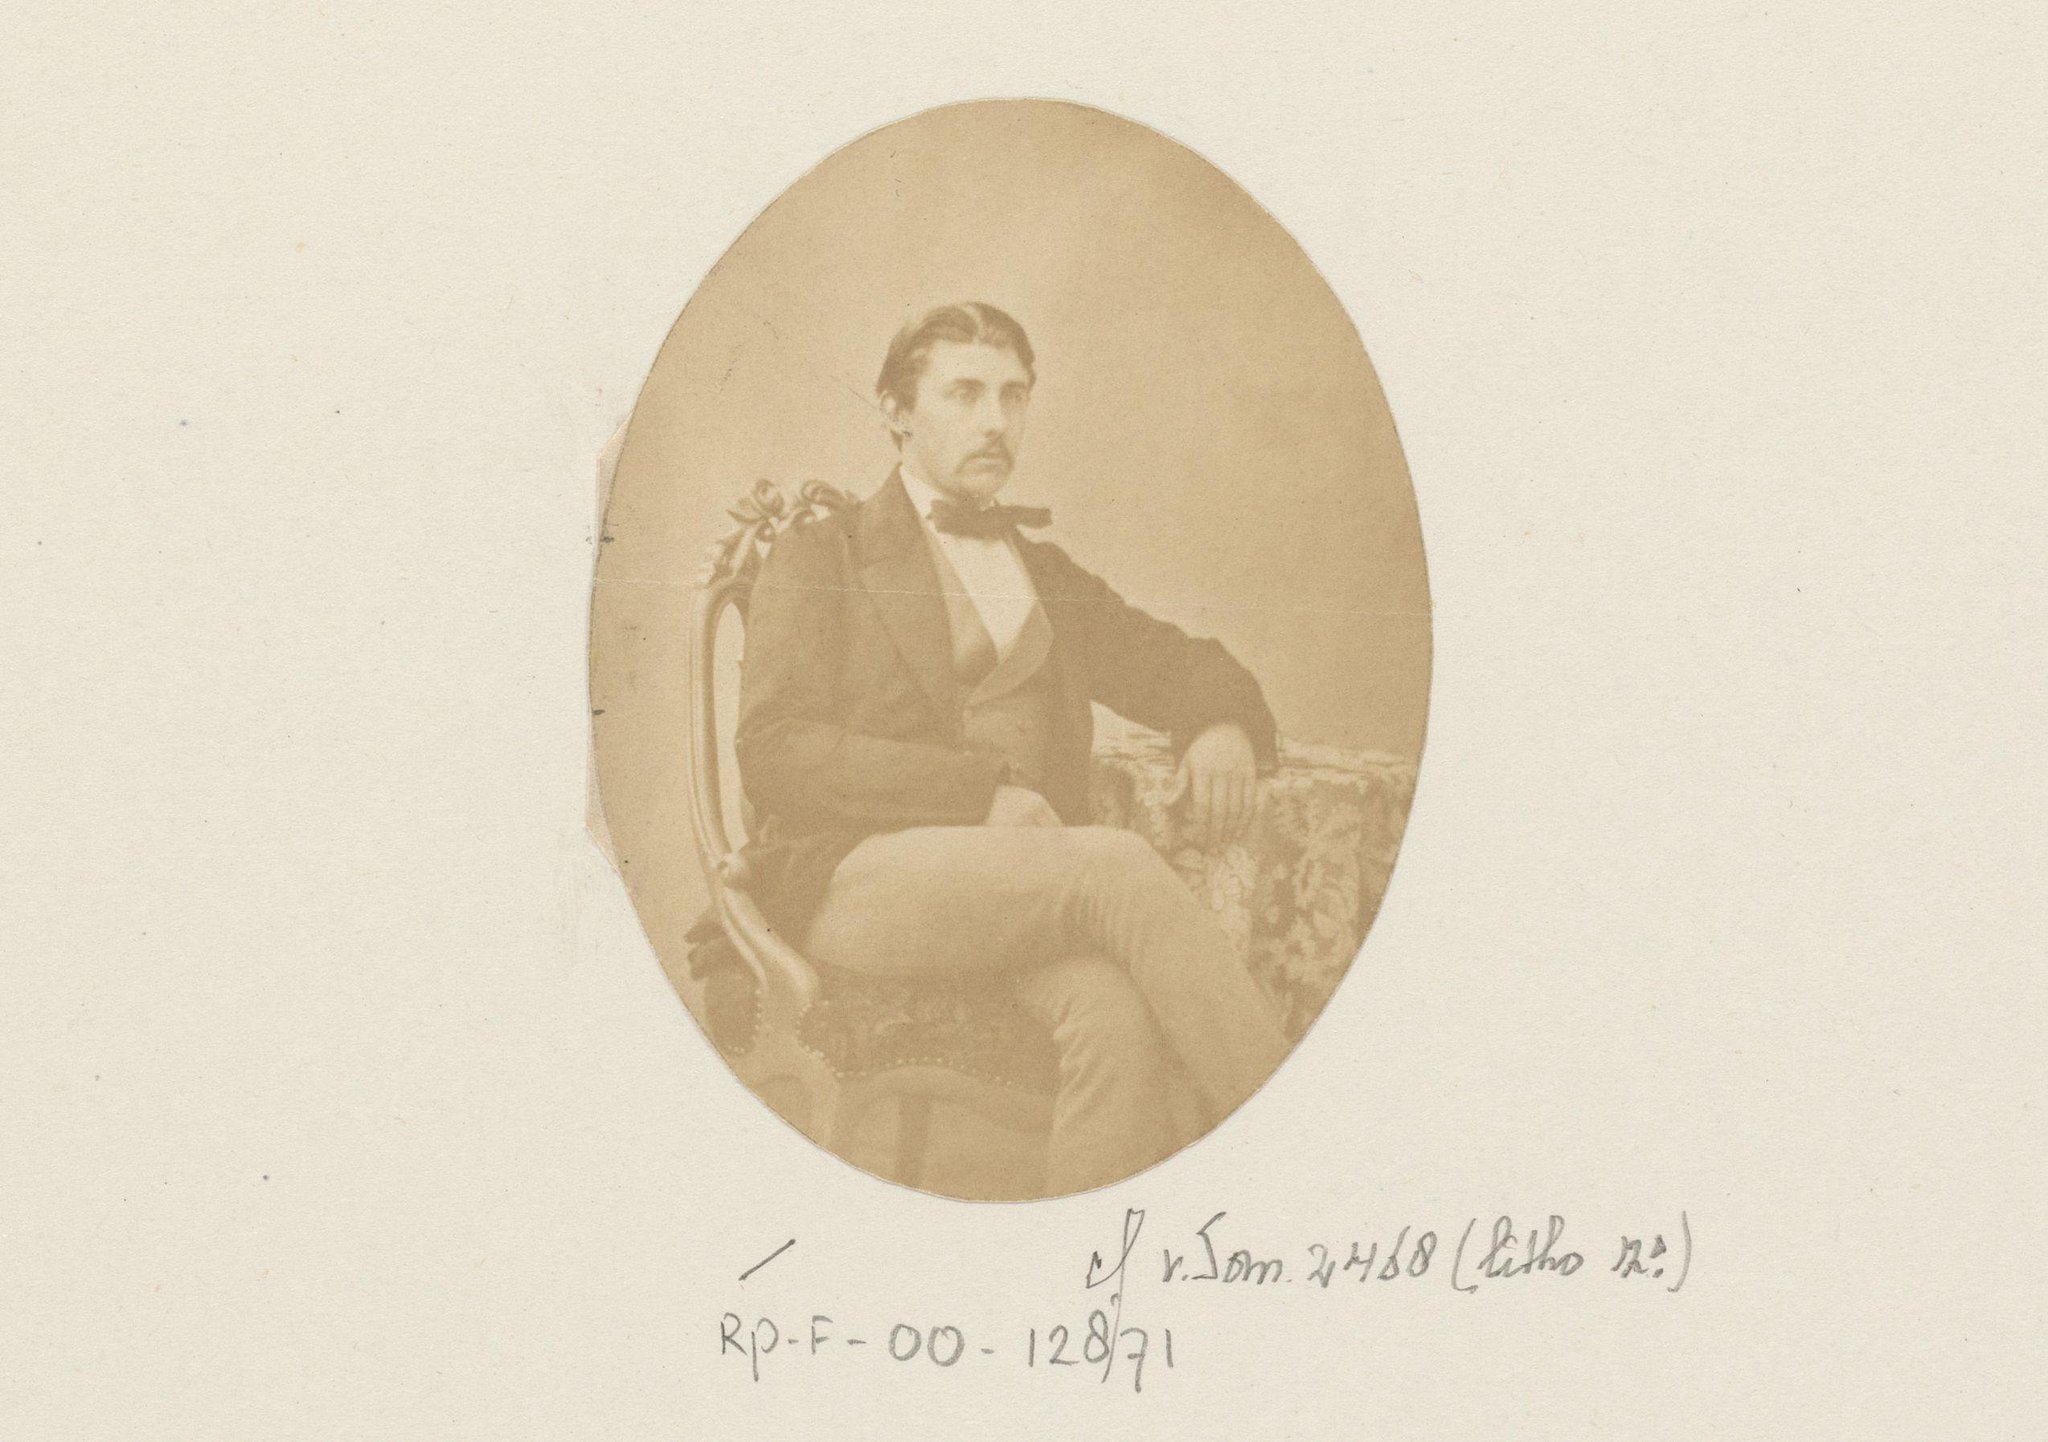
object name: photograph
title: Portret van Martin Hoek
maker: Anonymous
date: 1851-1873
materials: cardboard, paper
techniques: albumen print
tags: the hague, utrecht, print, e.g.: engraving, etching, lithograph, historical persons